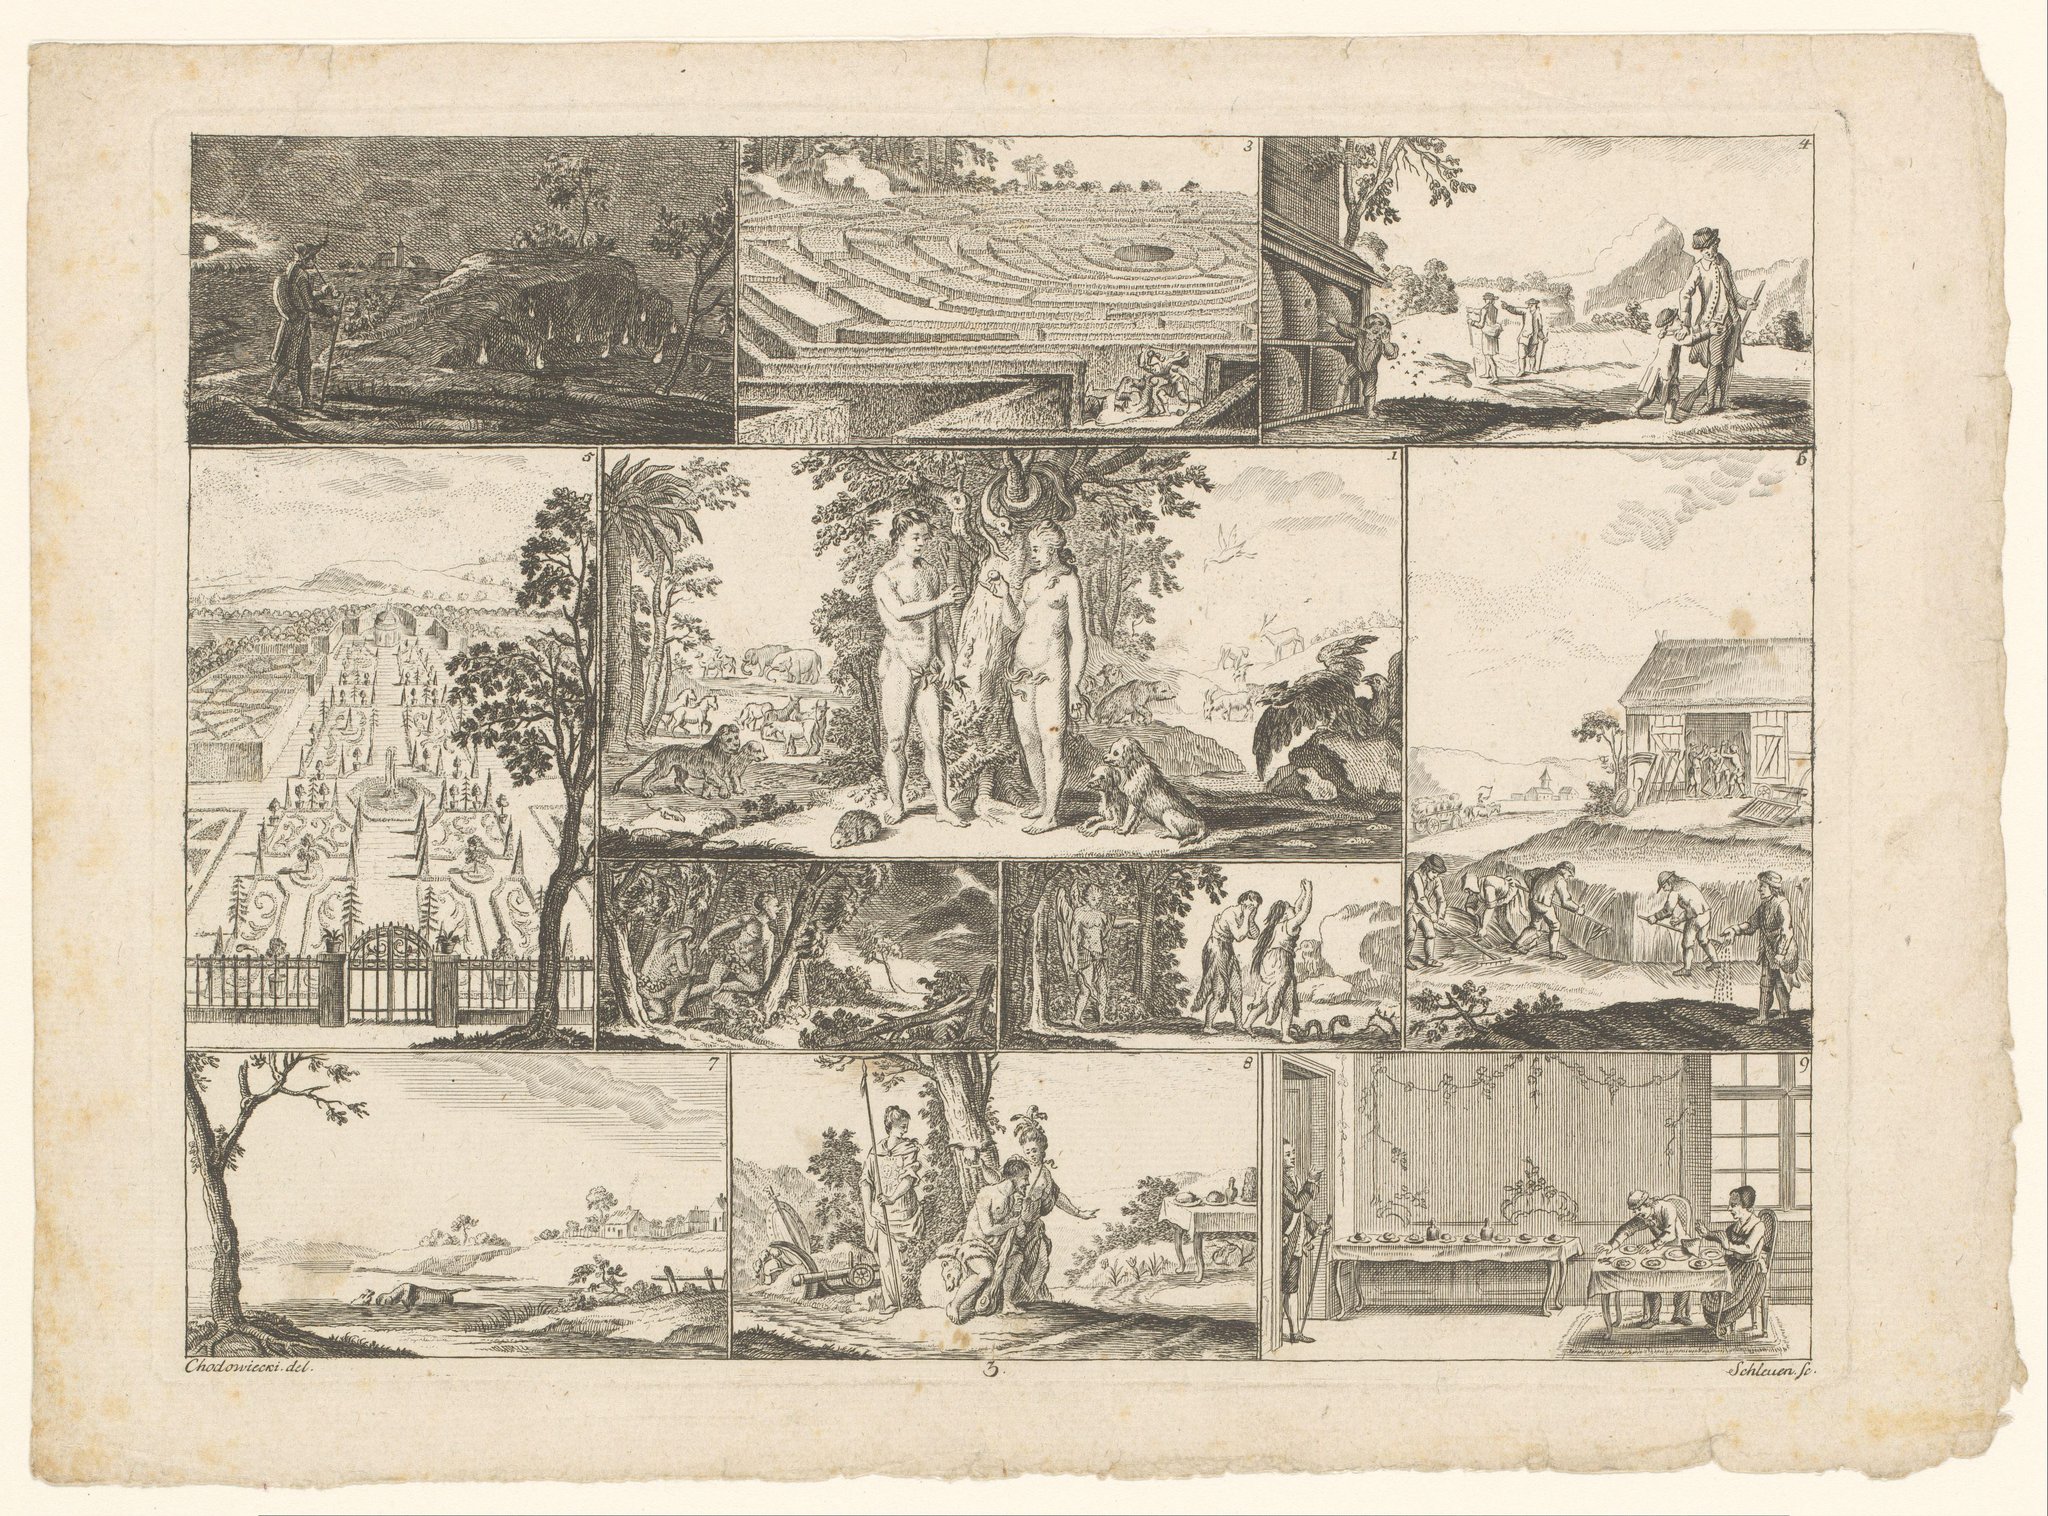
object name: print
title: Zondeval, omringd door uiteenlopende voorstellingen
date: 1784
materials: paper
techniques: engraving, etching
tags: theseus kills the minotaur, eve offers the fruit to adam, (story of) the minotaur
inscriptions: collector's mark: Lugt 2228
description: Maakt deel uit van een serie encyclopedische prenten door verschillende kunstenaars naar ontwerp van Daniel Nikolaus Chodowiecki bij Johann Sigmund Stoy's 'Bilder-Akademie für die Jugend', uitgegeven te Neurenberg in 1784. De prenten waren bedoeld voor kinderen om uit te knippen, op kaarten te plakken en vervolgens op logische wijze te rangschikken (zie Heesen, Anke te. The World in a Box: The Story of an Eighteenth-Century Picture Encyclopedia. Chicago: University of Chicago Press, 2002).